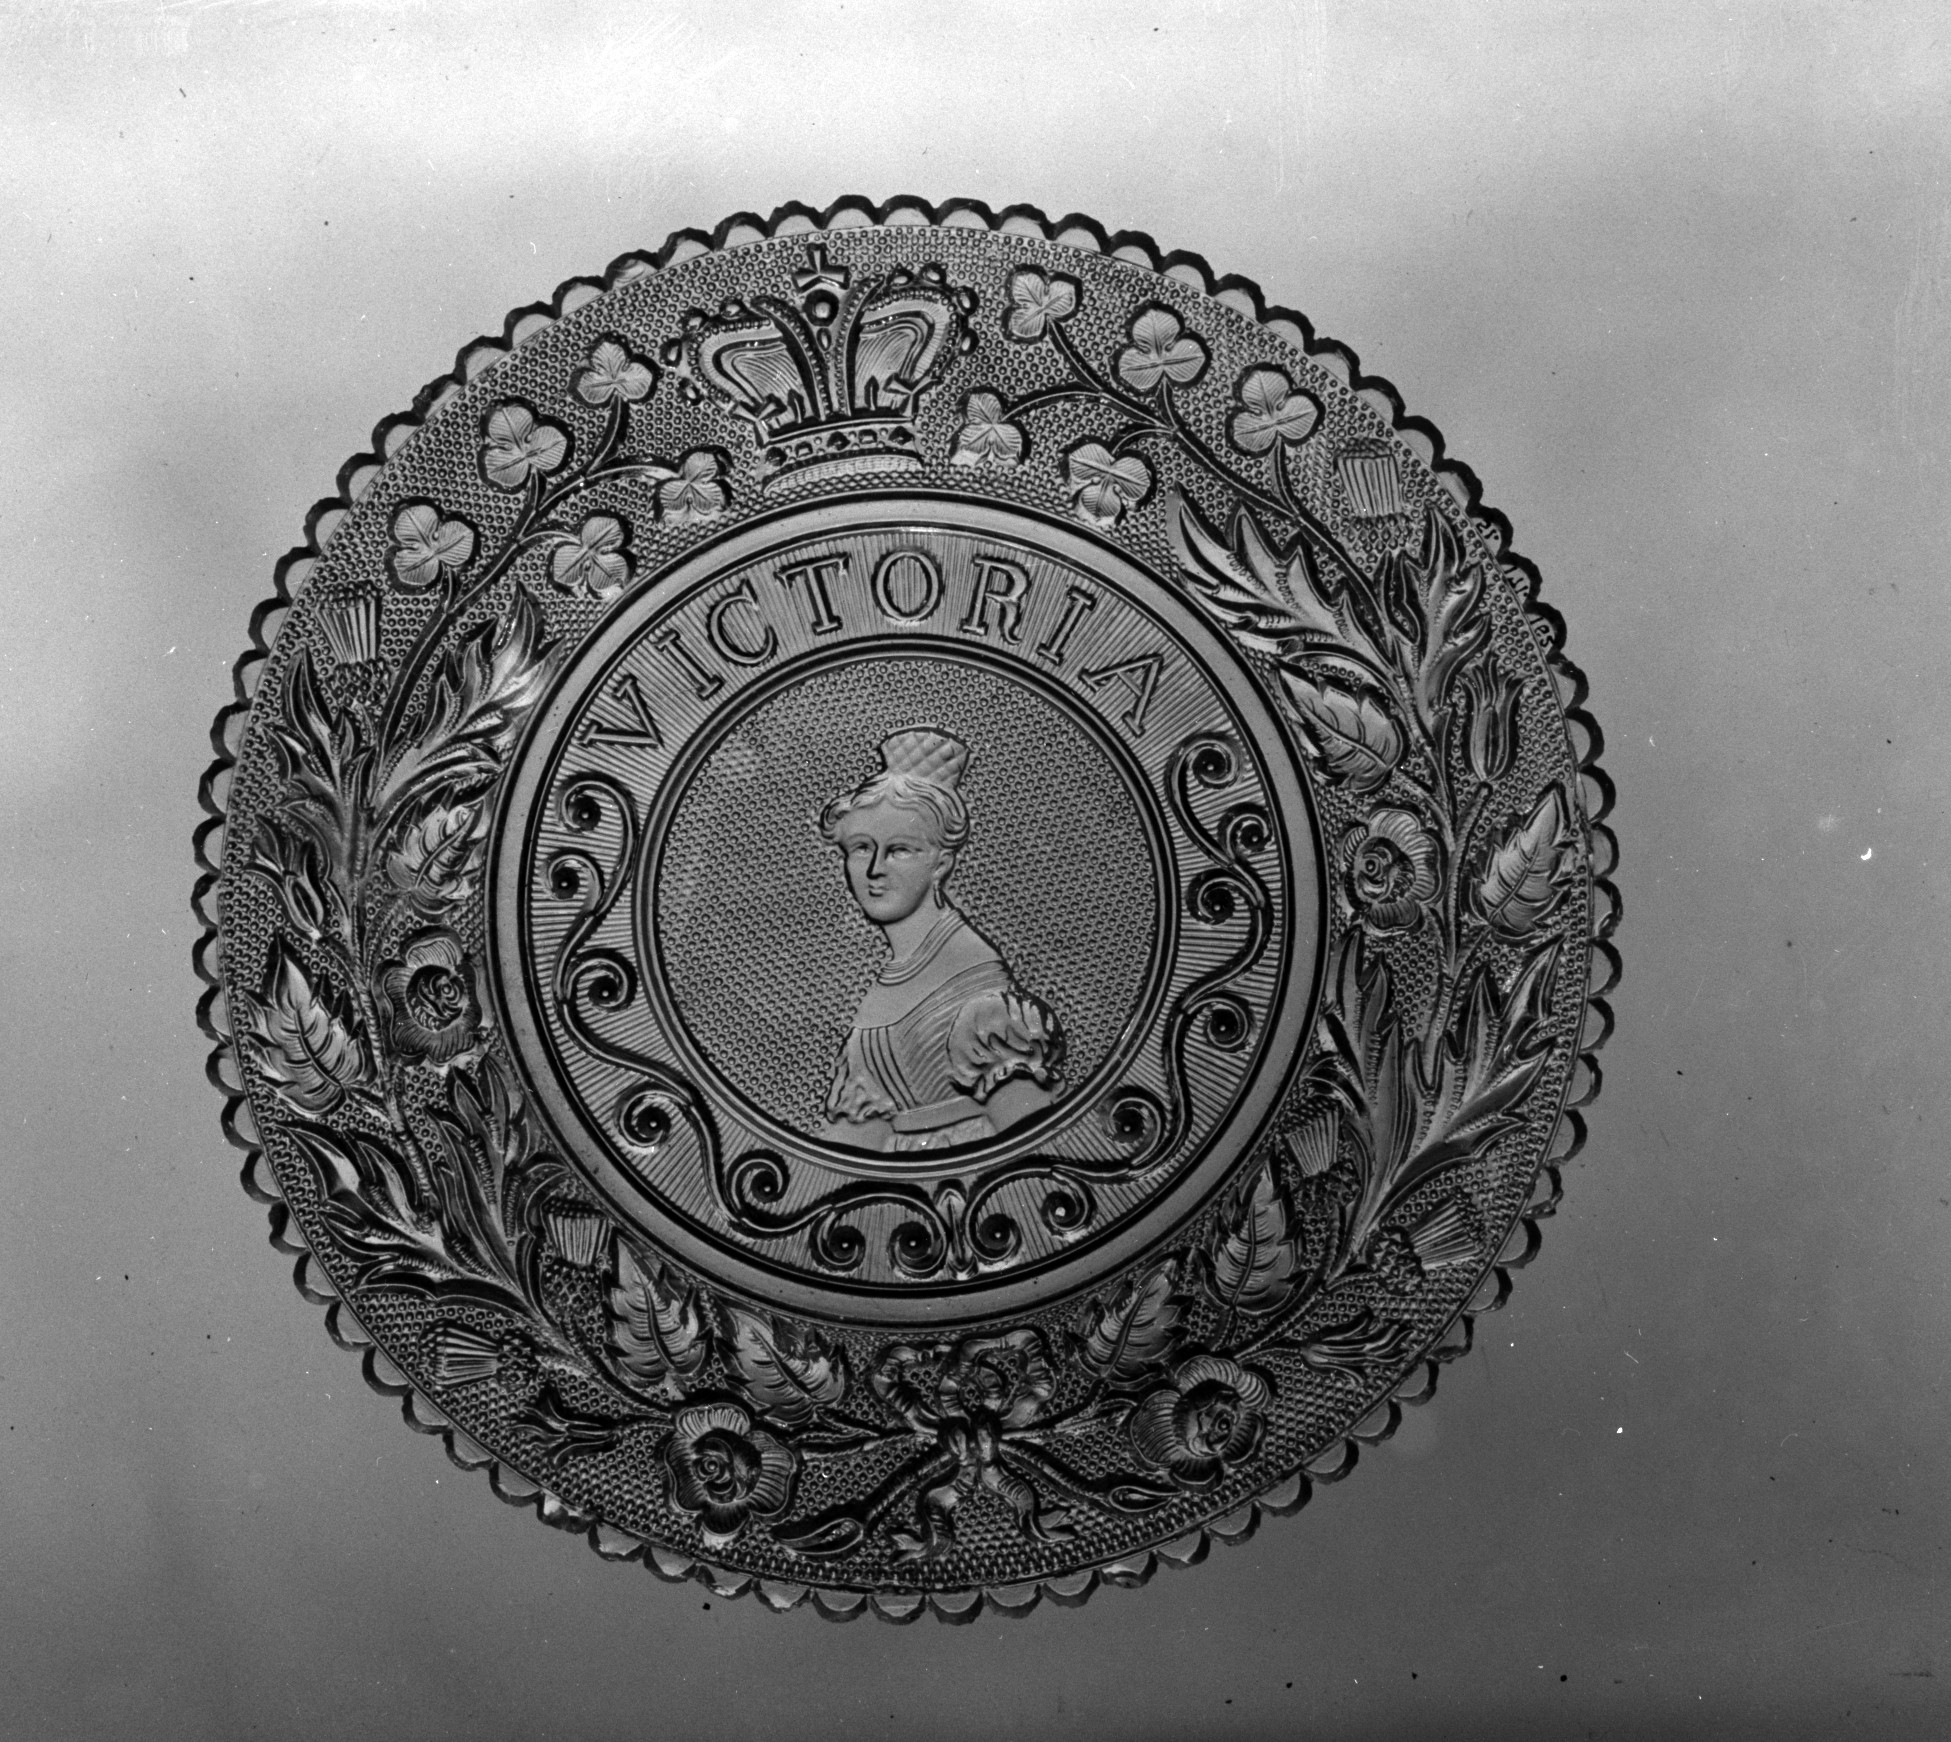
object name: plate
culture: american or british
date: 1837-1840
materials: glass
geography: england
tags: women,queen victoria